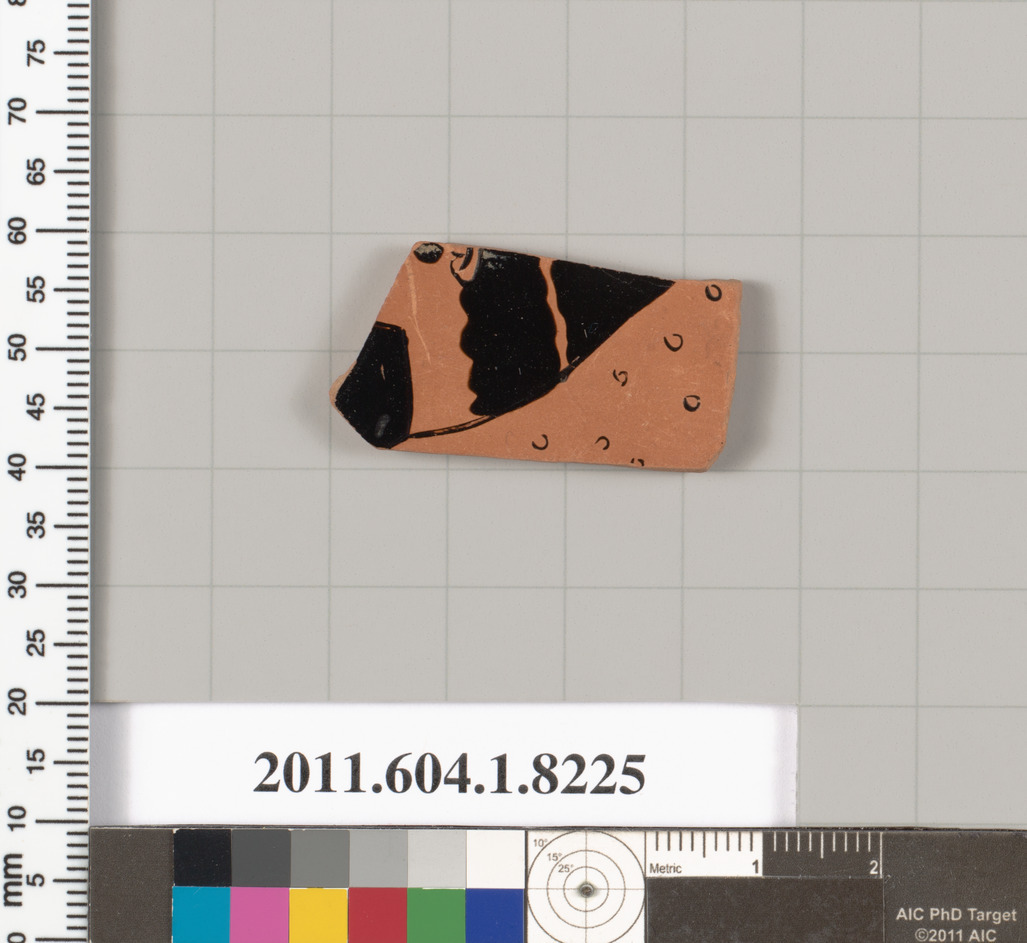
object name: kylix fragment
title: Terracotta fragment of a kylix (drinking cup)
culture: greek, attic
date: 520-510 BCE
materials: terracotta